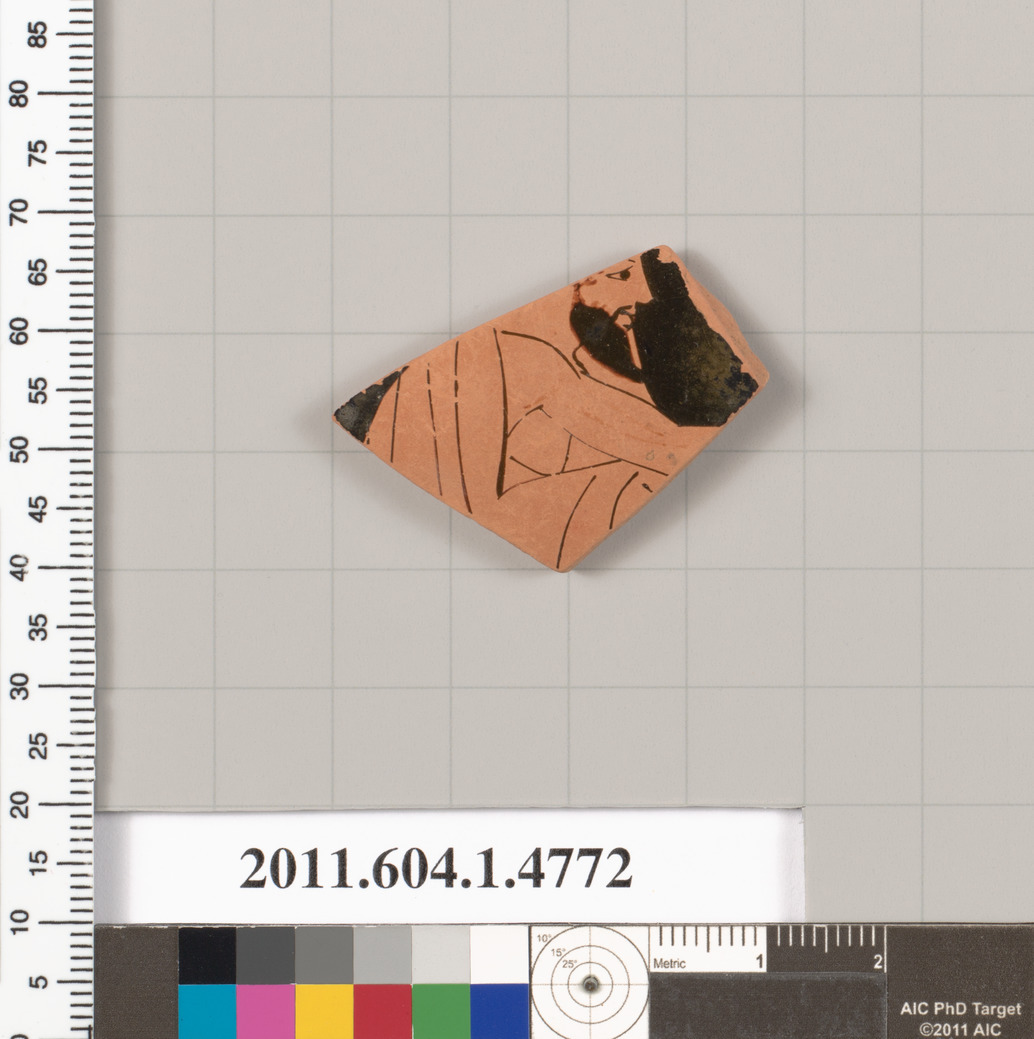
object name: kylix fragment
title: Terracotta fragment of a kylix (drinking cup)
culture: greek, attic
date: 490-470 BCE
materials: terracotta